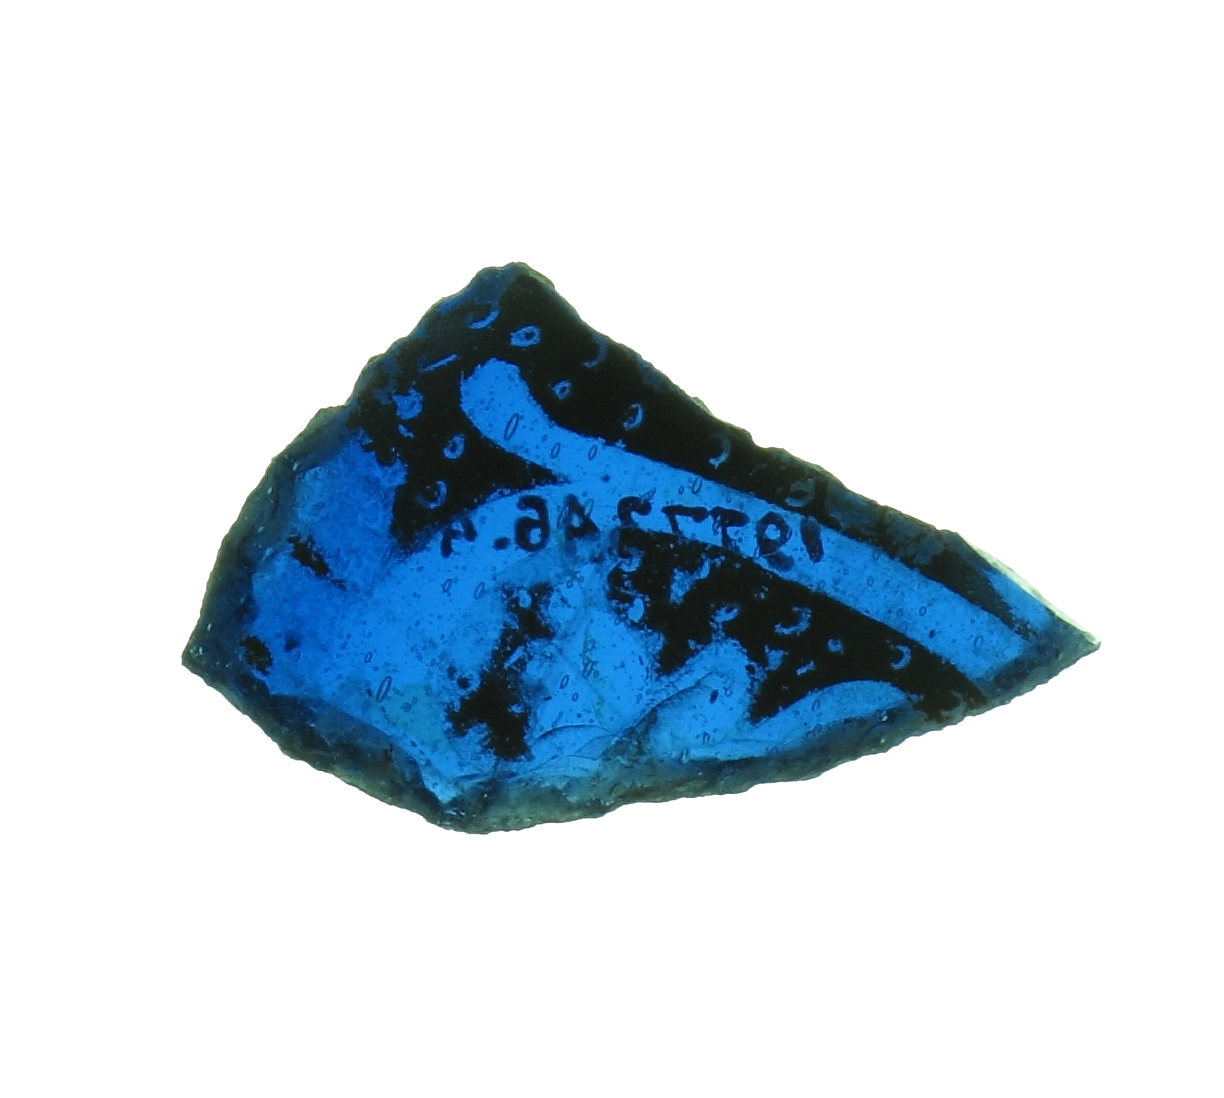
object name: fragment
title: Glass Fragment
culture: french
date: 1101-1400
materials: glass, metal, paint